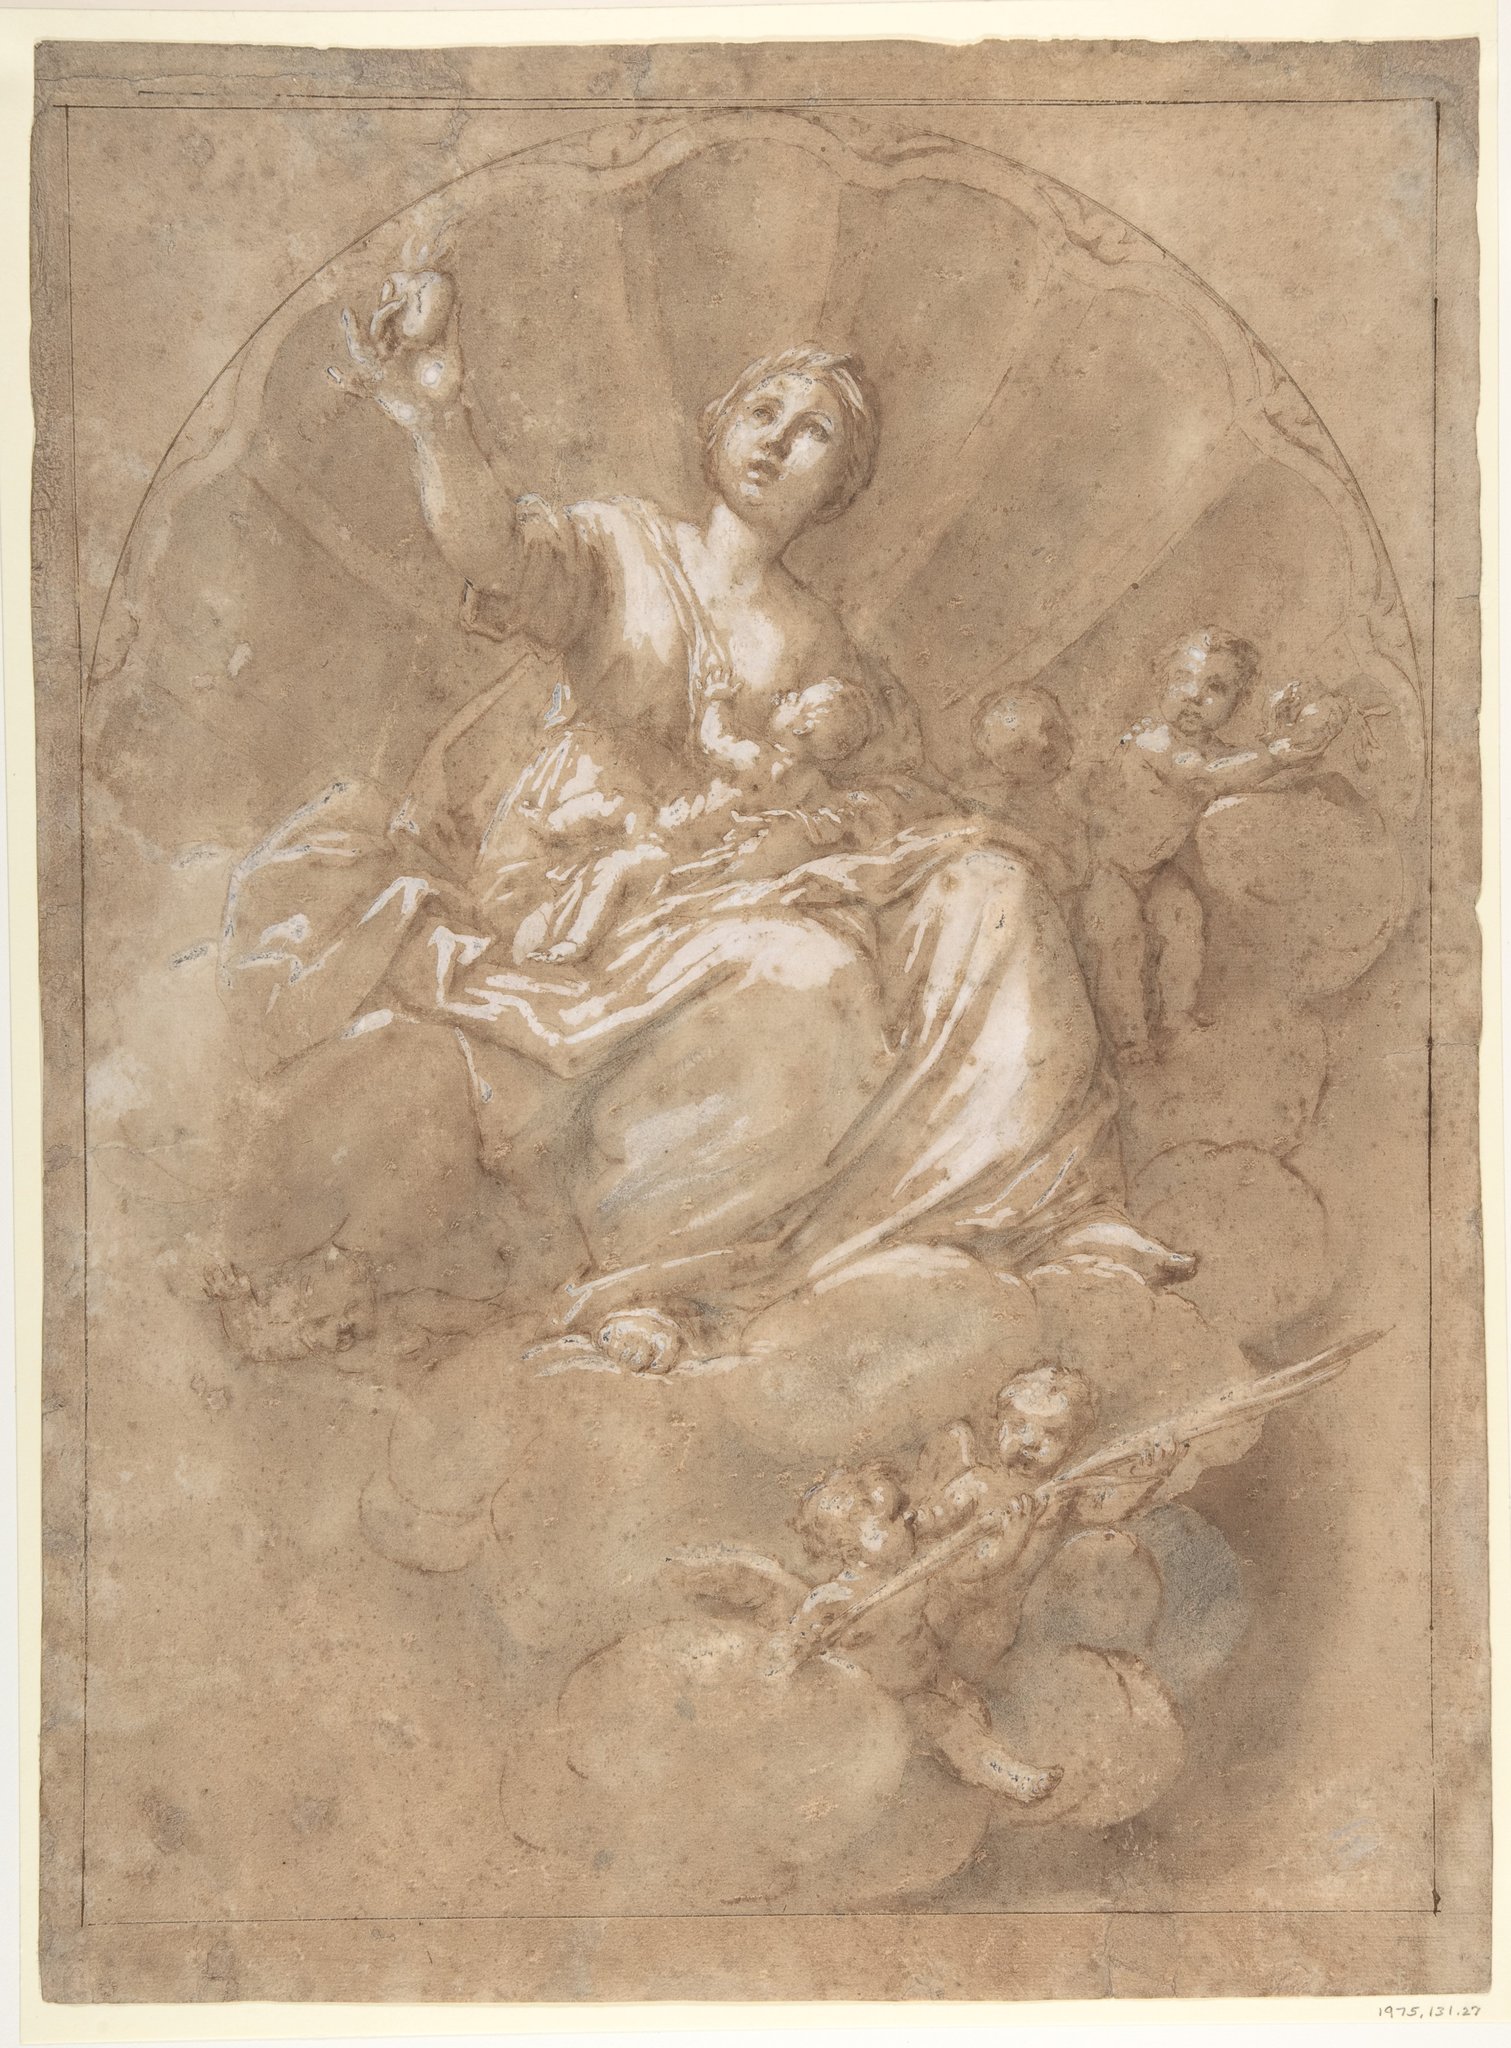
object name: drawing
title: Allegorical Figure of Charity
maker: marcantonio franceschini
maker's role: artist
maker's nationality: italian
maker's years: 1648-1729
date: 1688-1689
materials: ink, paper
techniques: brush, highlighting, pen, wash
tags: fruit,infants,women